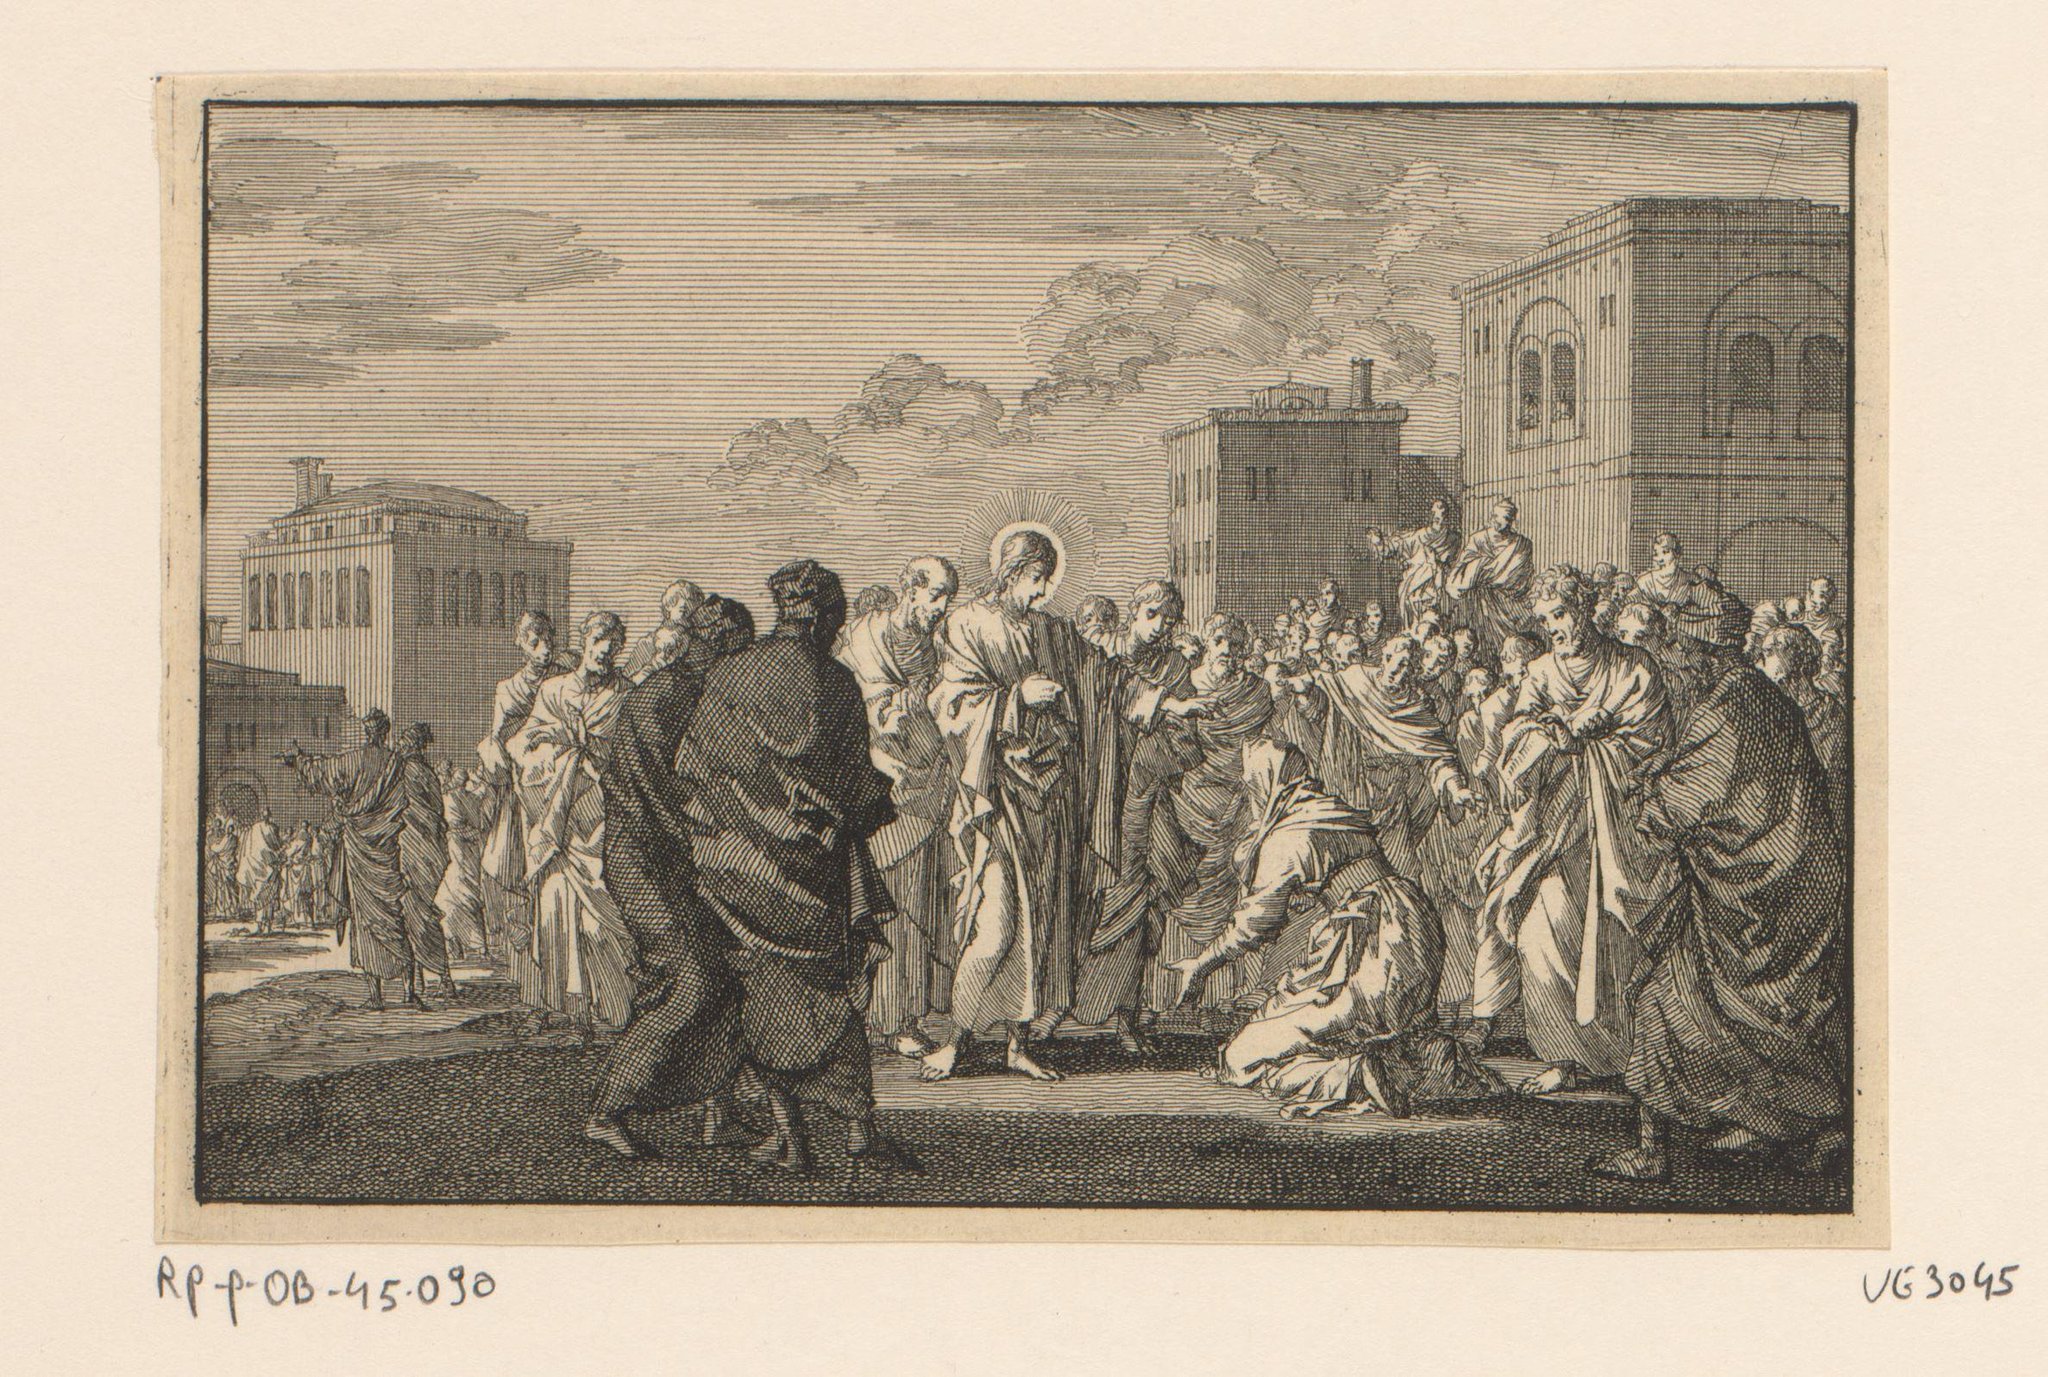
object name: print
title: Genezing van een vrouw die aan bloedvloeiingen leed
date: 1703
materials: paper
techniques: etching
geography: haarlem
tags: healing of a woman with an issue of blood: she kneels before christ after having touched his robe (matthew 9:20-22; mark 5:25-34; luke 8:43-48)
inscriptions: collector's mark: Lugt 2228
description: Proefdruk van een boekillustratie voor David Martin. Historie des Ouden en Nieuwen Testaments. Amsterdam, Pieter Mortier, 1703. Deel II. De boekillustraties voor de Mortierbijbel hebben verschillende staten en kopieën, waarbij de chronologische volgorde moeilijk te achterhalen valt. Als boekillustraties werden ze bovendien herhaaldelijk opnieuw gebruikt voor andere boekwerken.